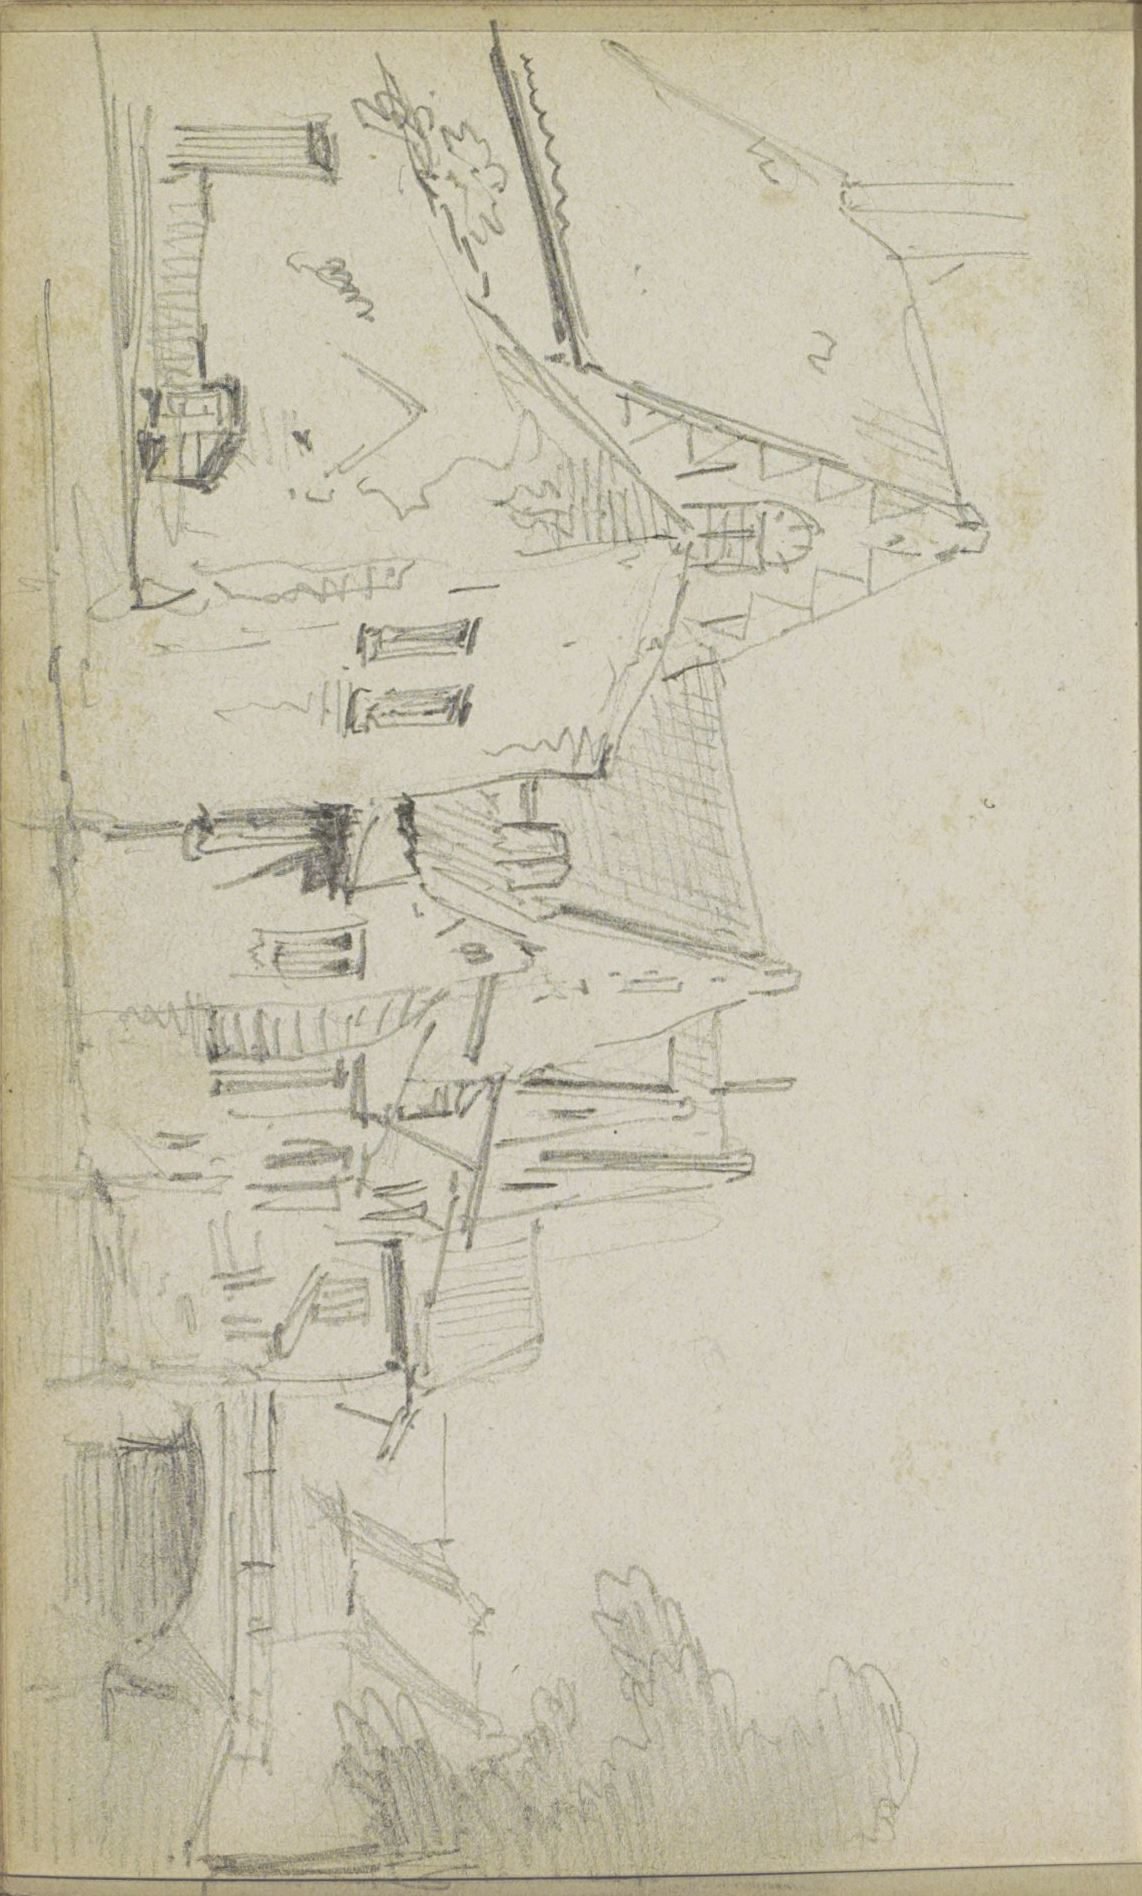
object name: sketchbook leaf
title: Gezicht op huizen langs een gracht, mogelijk te Oudewater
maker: adrianus eversen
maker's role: draughtsman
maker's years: 1818-1897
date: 1828-1897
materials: paper, pencil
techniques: stumping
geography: netherlands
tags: urban housing, bridge in city across river, canal, etc.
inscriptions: kleurnotitie, handgeschreven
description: Gezicht op een gracht met een brug, mogelijk te Oudewater. Langs de gracht staan huizen. Rechts een boom. Blad 56 verso uit een schetsboek met 69 bladen vervaardigd in de omgeving van Delft, Rotterdam, Oudewater en Harlingen.